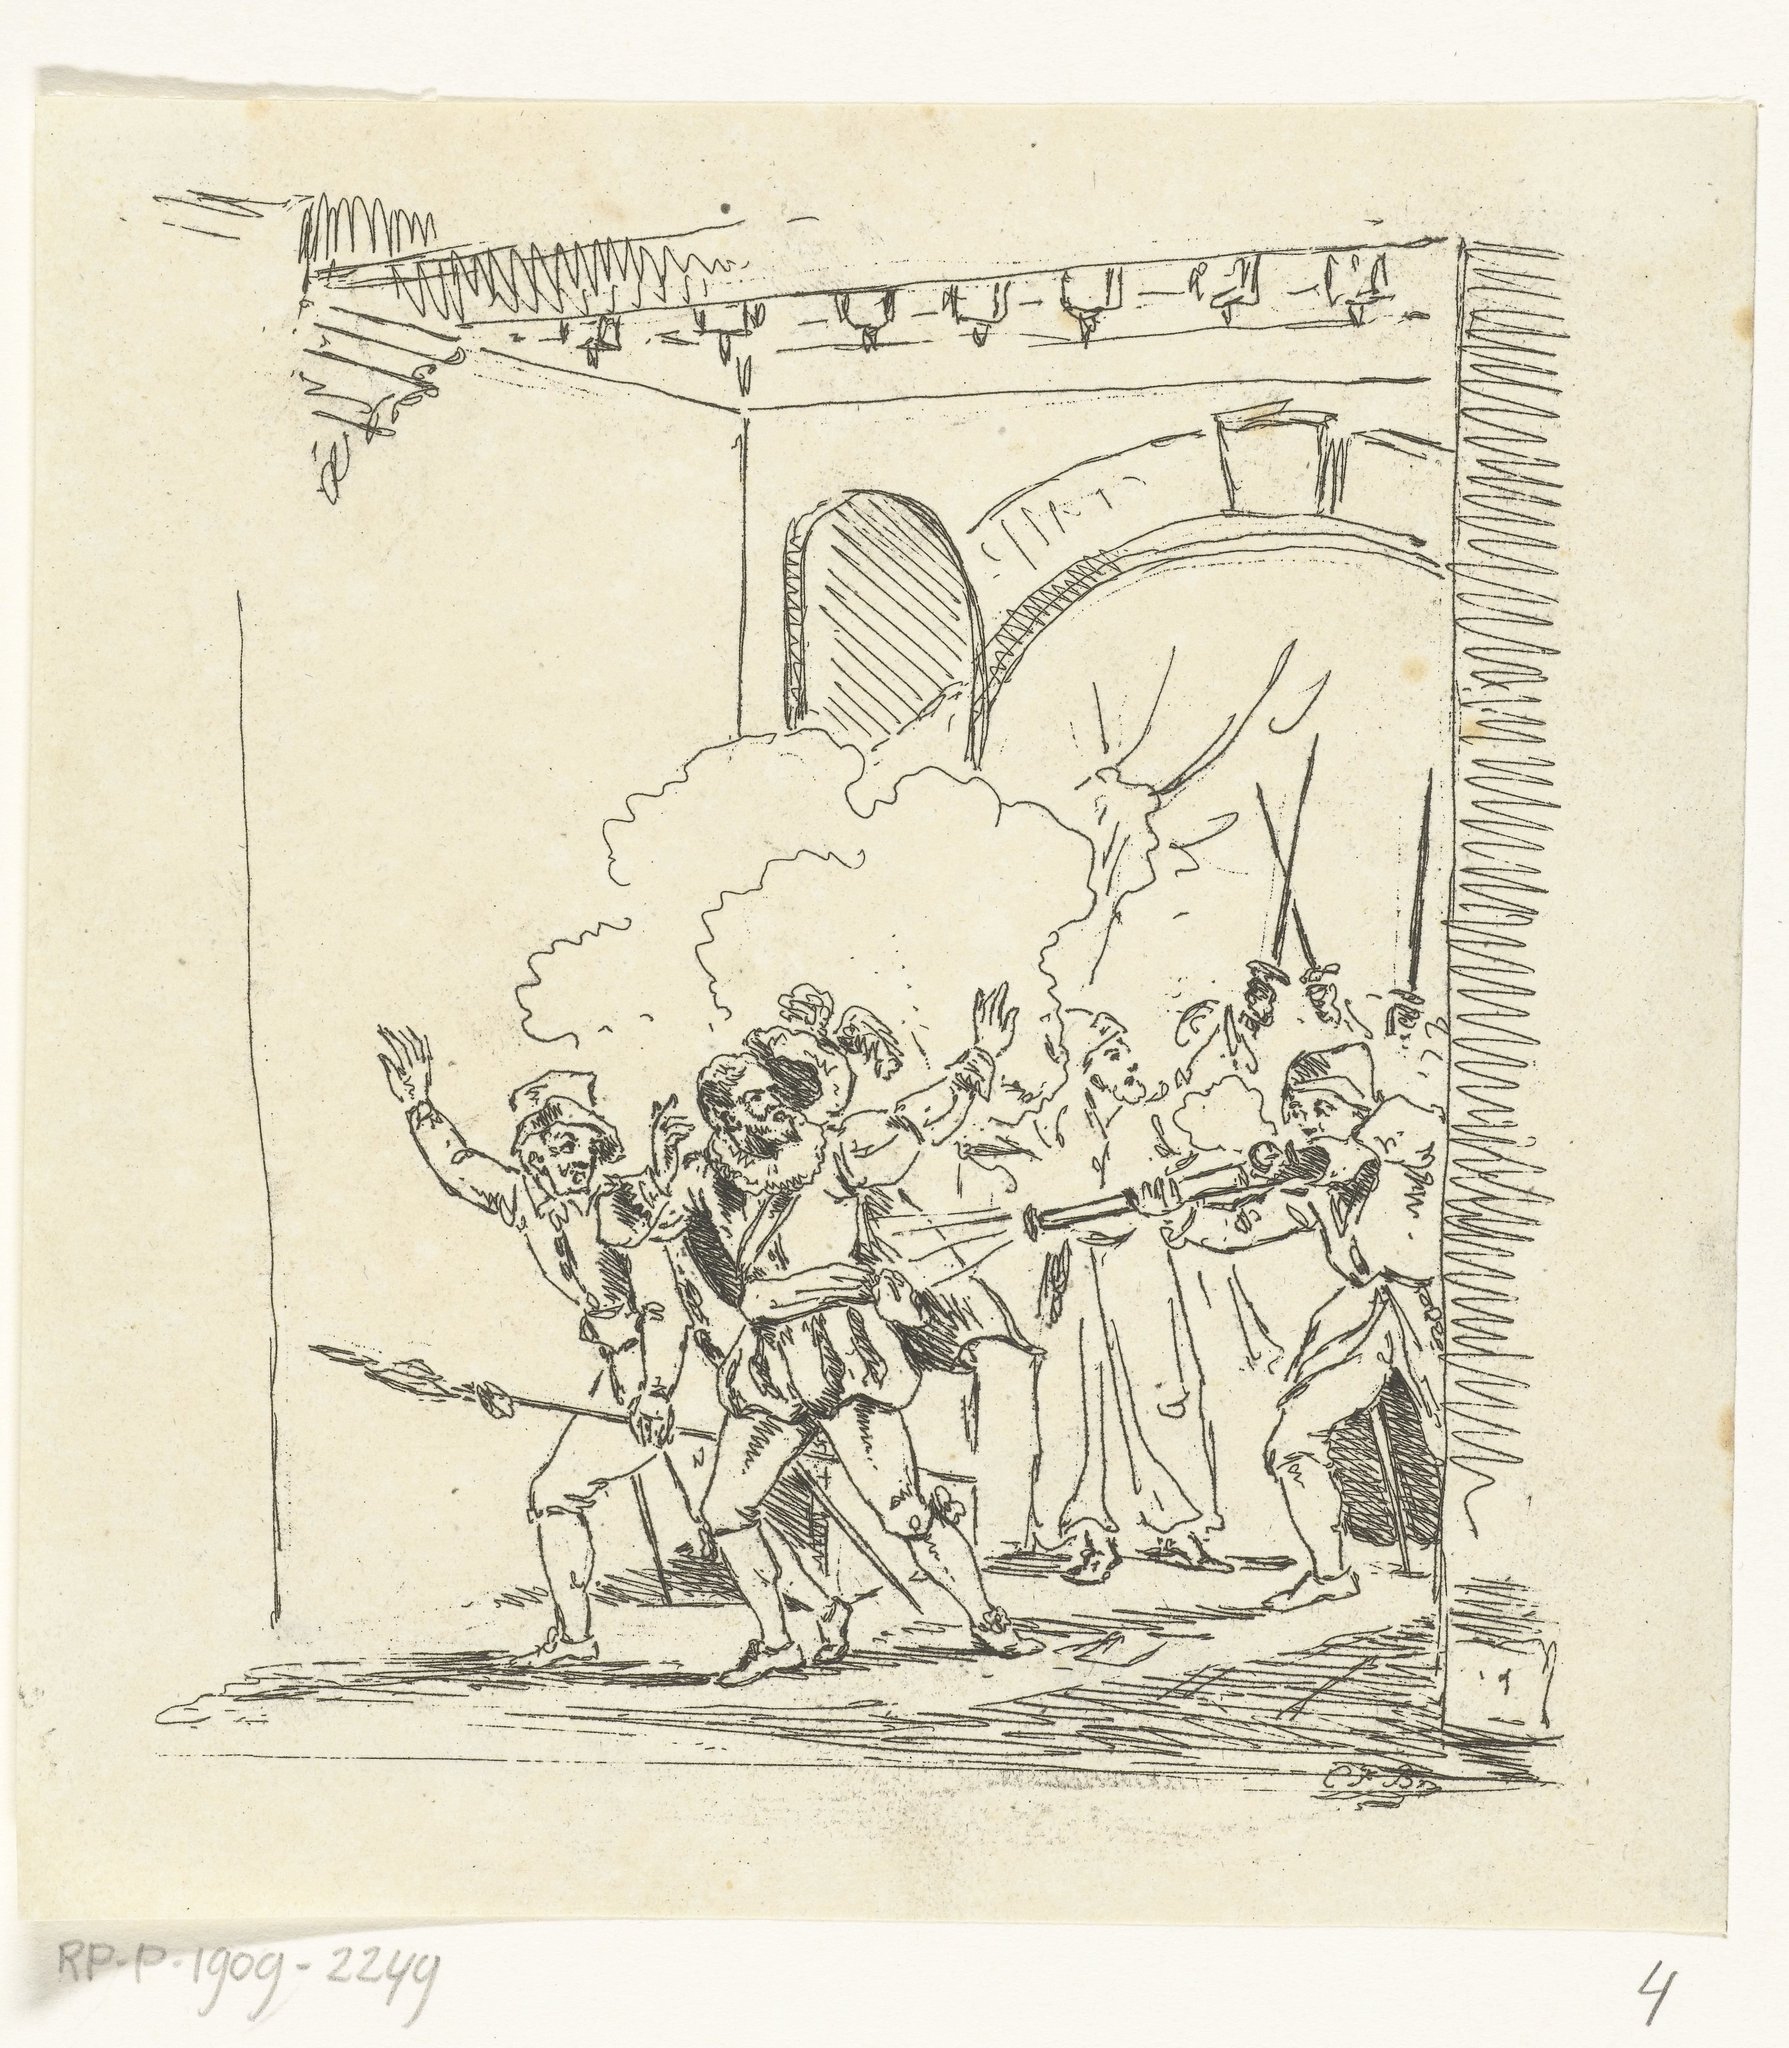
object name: print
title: Soldaten breken door toegang fort en schieten man neer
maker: carel frederik bendorp (ii)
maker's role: draughtsman, painter, print maker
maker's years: 1819-1897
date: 1829-1897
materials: paper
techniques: etching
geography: netherlands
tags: violent death by firearms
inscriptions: collector's mark: Lugt 1485, collector's mark: Lugt 2228